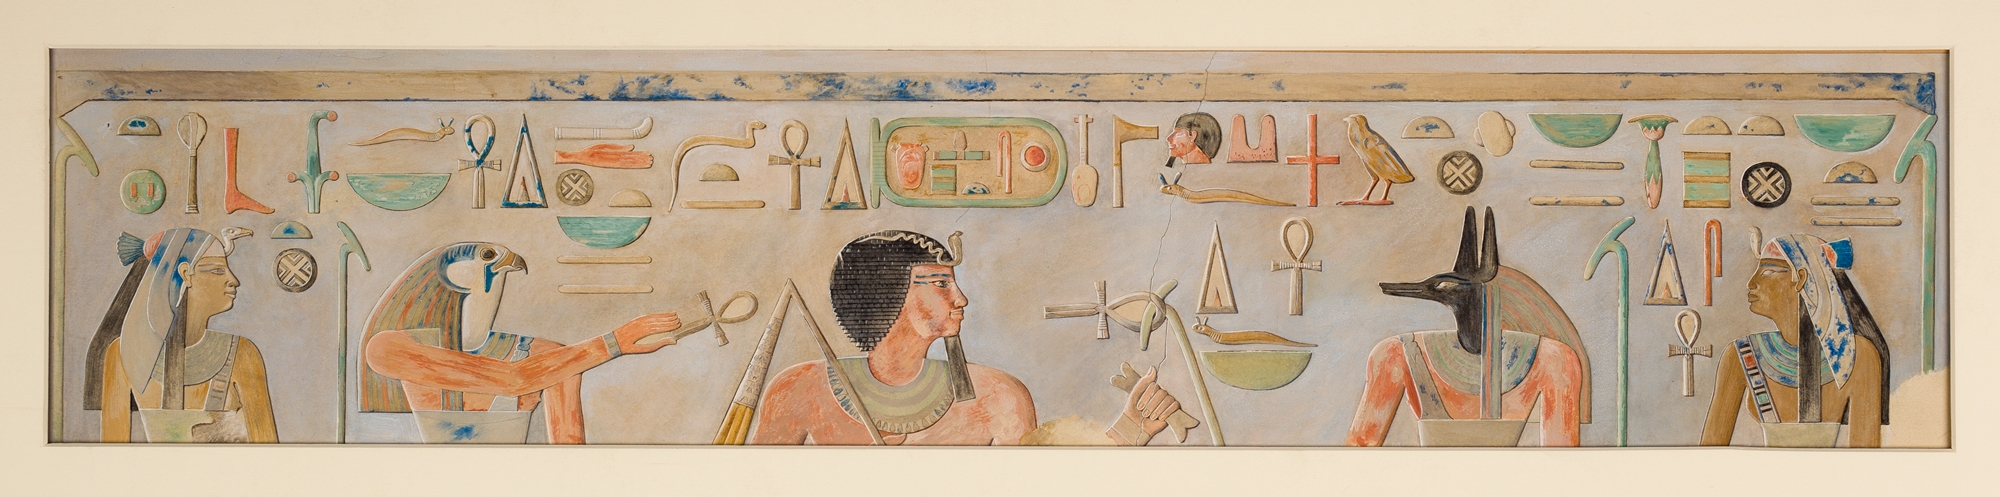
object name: facsimile, amenemhat i temple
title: Lintel, Pyramid Temple of Amenemhat I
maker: unknown copyist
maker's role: artist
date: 1981-1952 BCE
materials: paper, paint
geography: egypt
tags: men,women,hieroglyphs,ankh